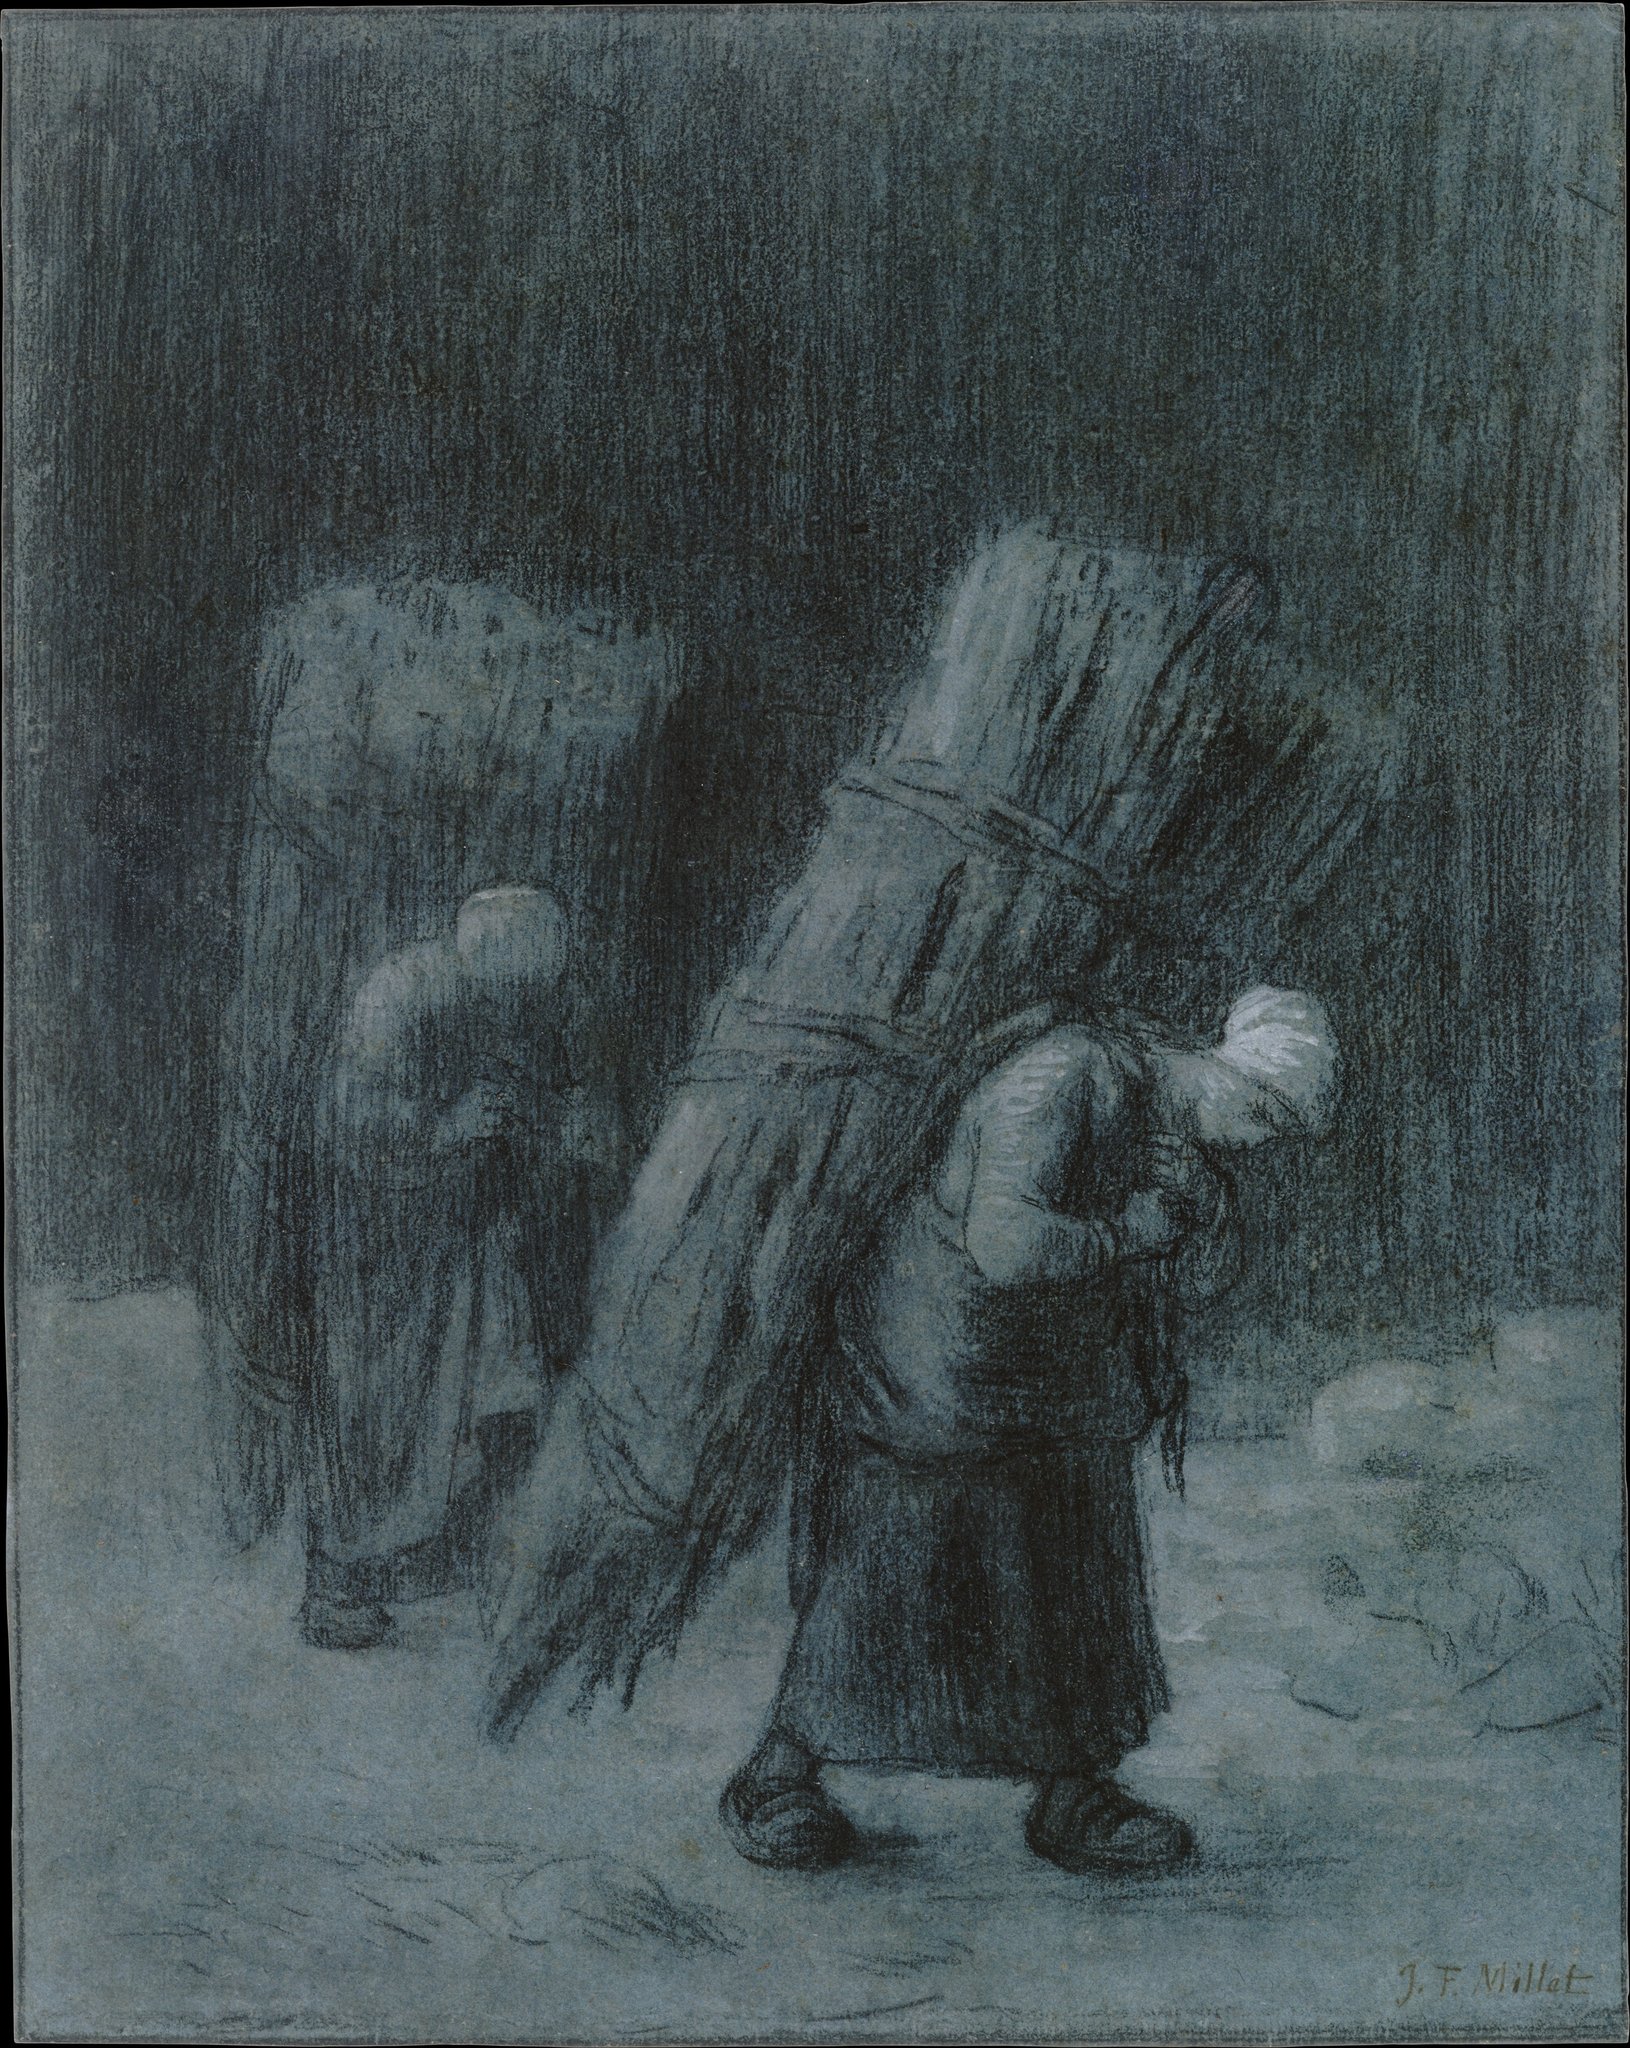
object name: drawing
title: Women Carrying Faggots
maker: jean-françois millet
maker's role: artist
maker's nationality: french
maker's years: 1814-1875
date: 1858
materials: charcoal, gouache, paper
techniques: heightening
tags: women,working